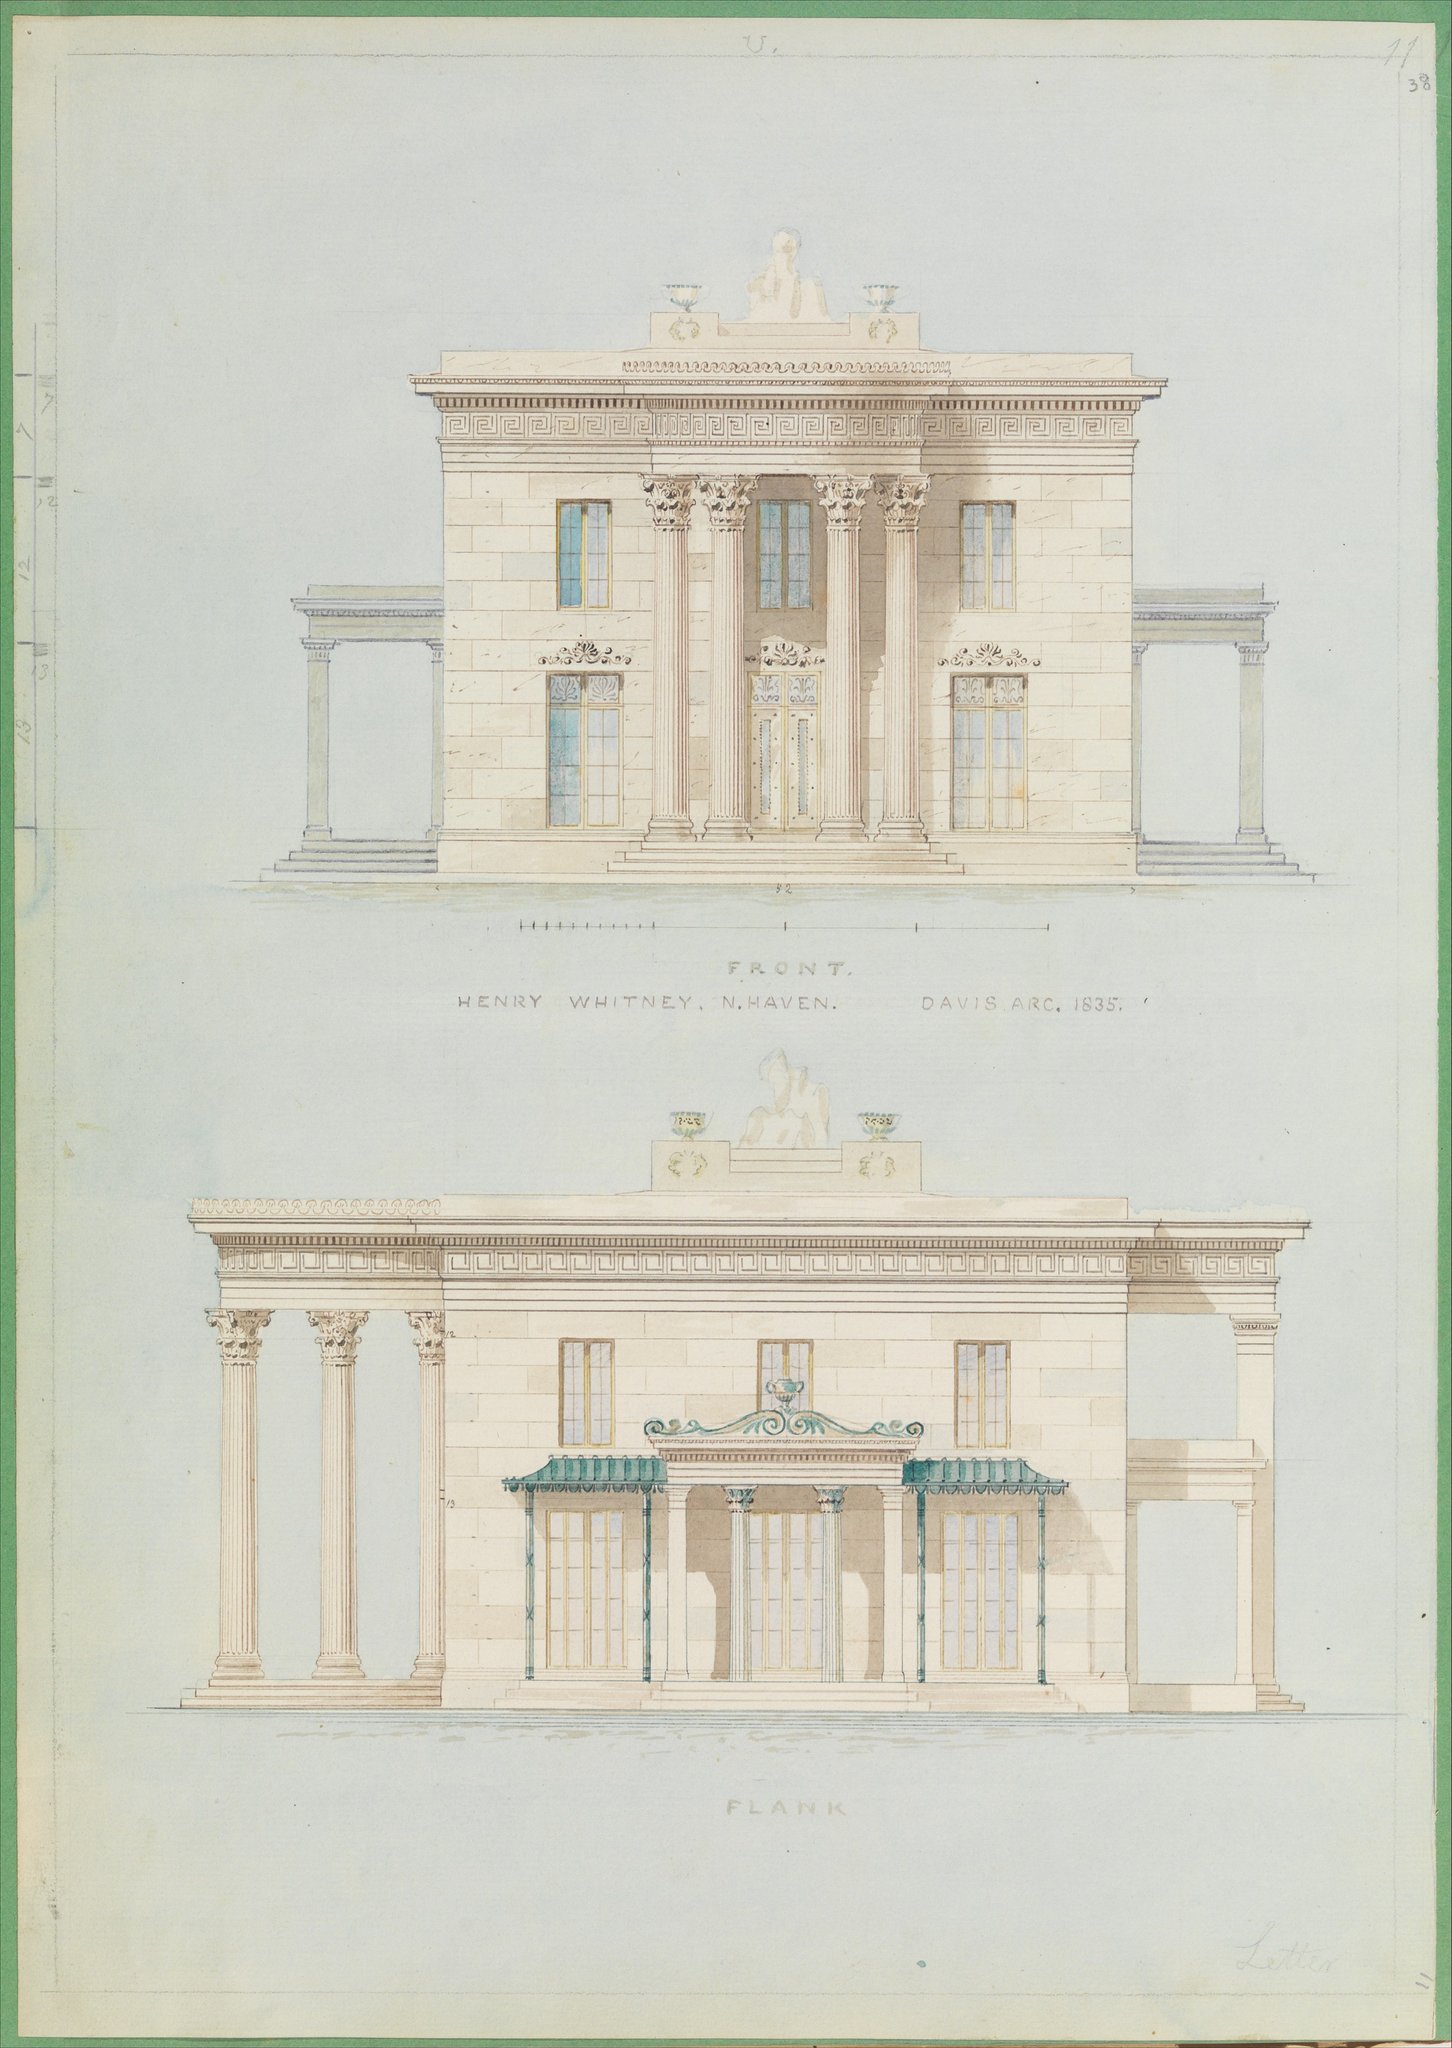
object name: drawing ornament architecture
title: House for Henry Whitney, New Haven, Connecticut (front and side elevations)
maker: alexander jackson davis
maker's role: artist and architect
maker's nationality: american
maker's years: 1803-1892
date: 1835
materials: graphite, ink, watercolor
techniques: pen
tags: buildings